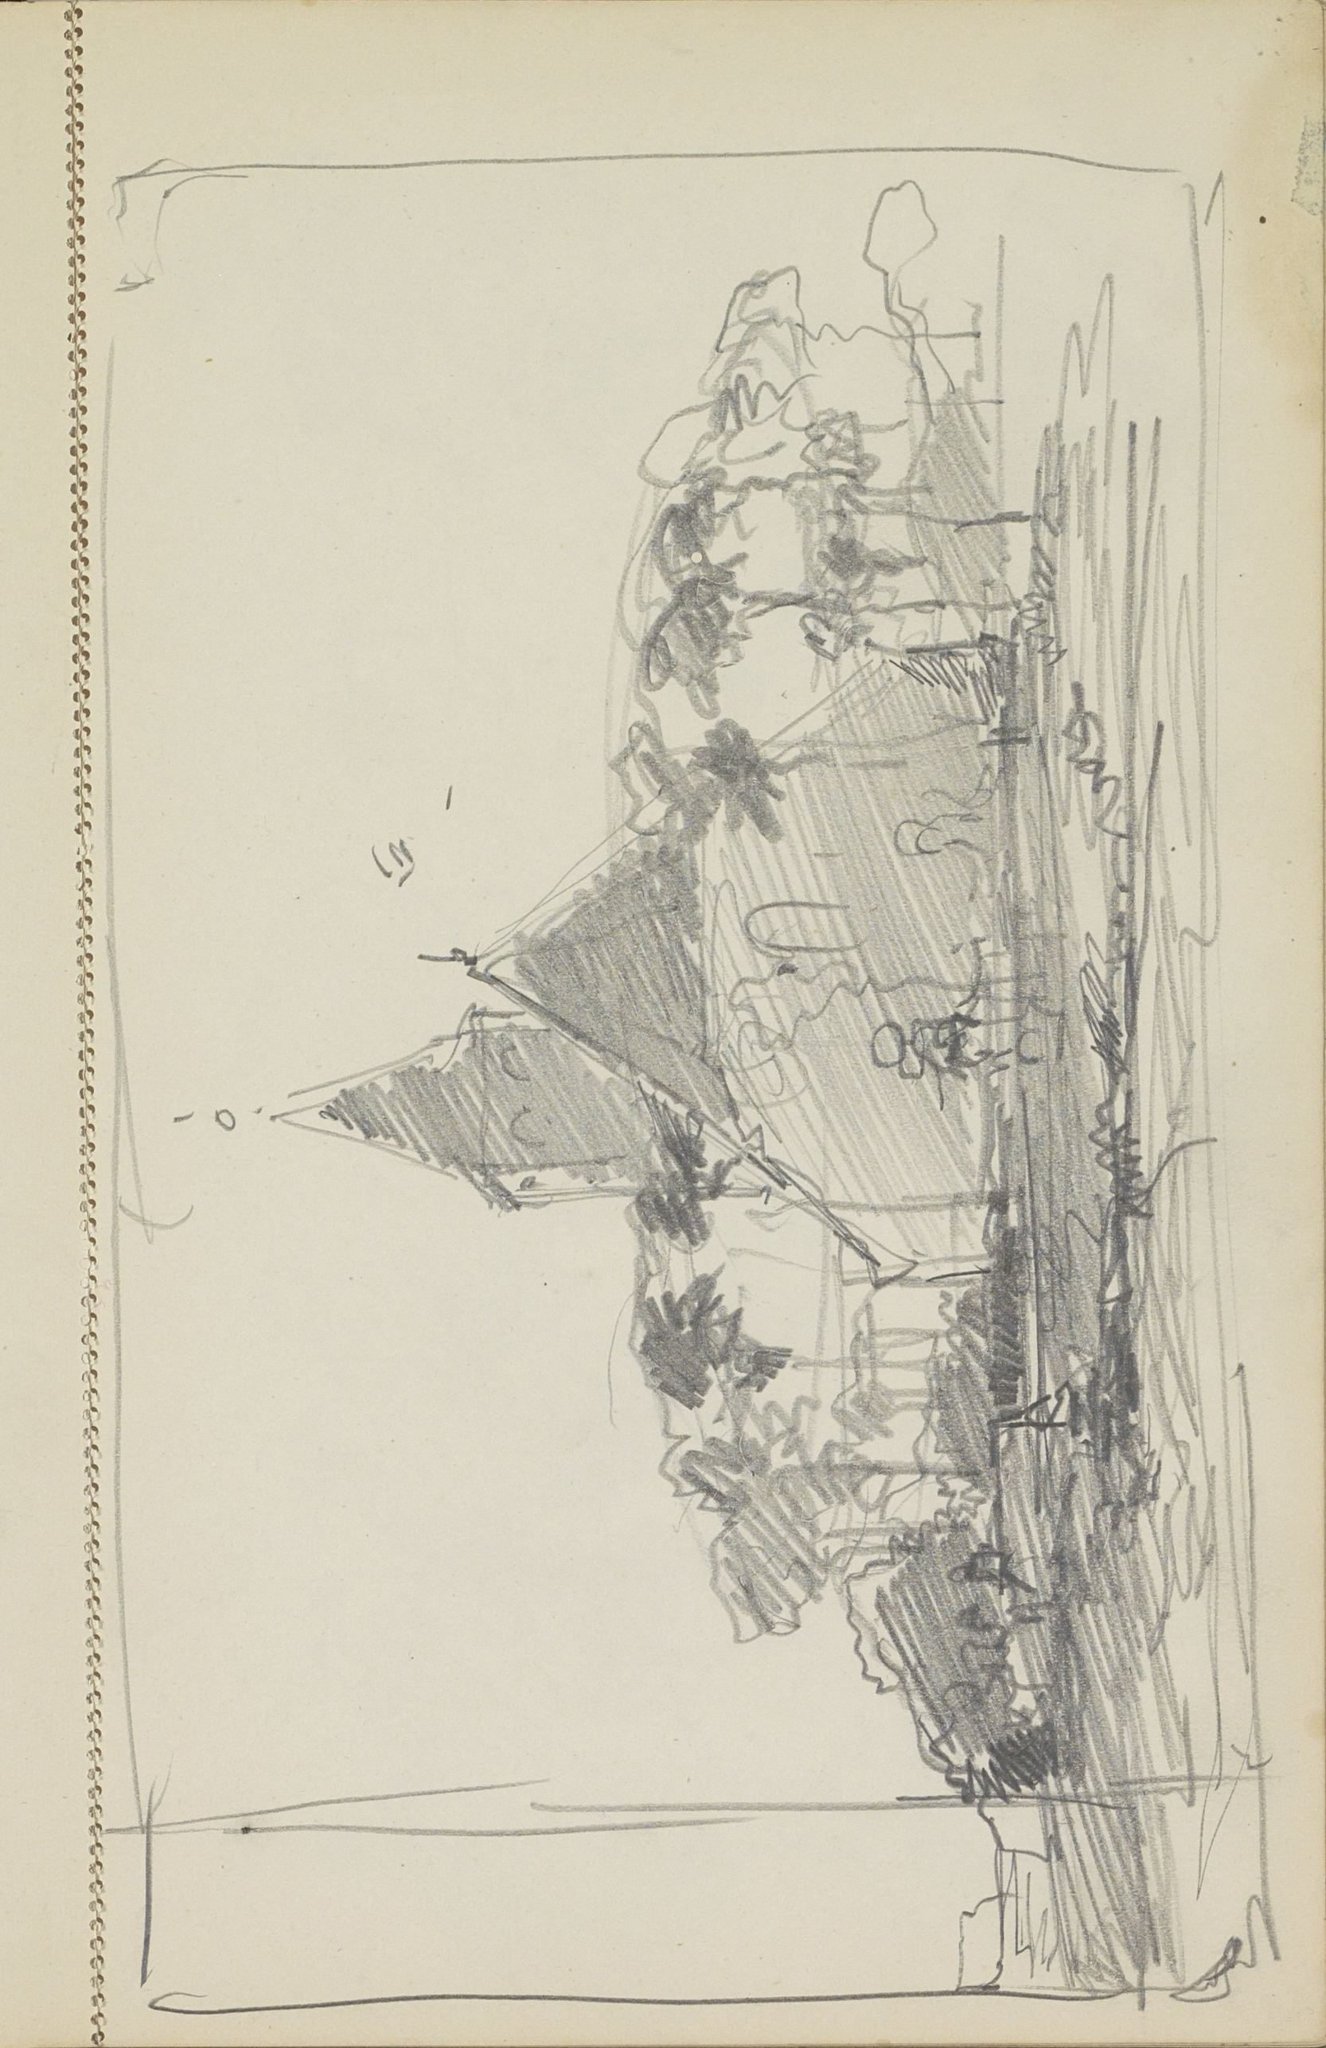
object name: sketchbook leaf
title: Kerk omringd door bomen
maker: cornelis vreedenburgh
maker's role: draughtsman, print maker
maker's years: 1880-1946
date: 1890-1946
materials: paper, pencil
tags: church (exterior)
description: Blad 27 recto uit een schetsboek met 56 bladen.